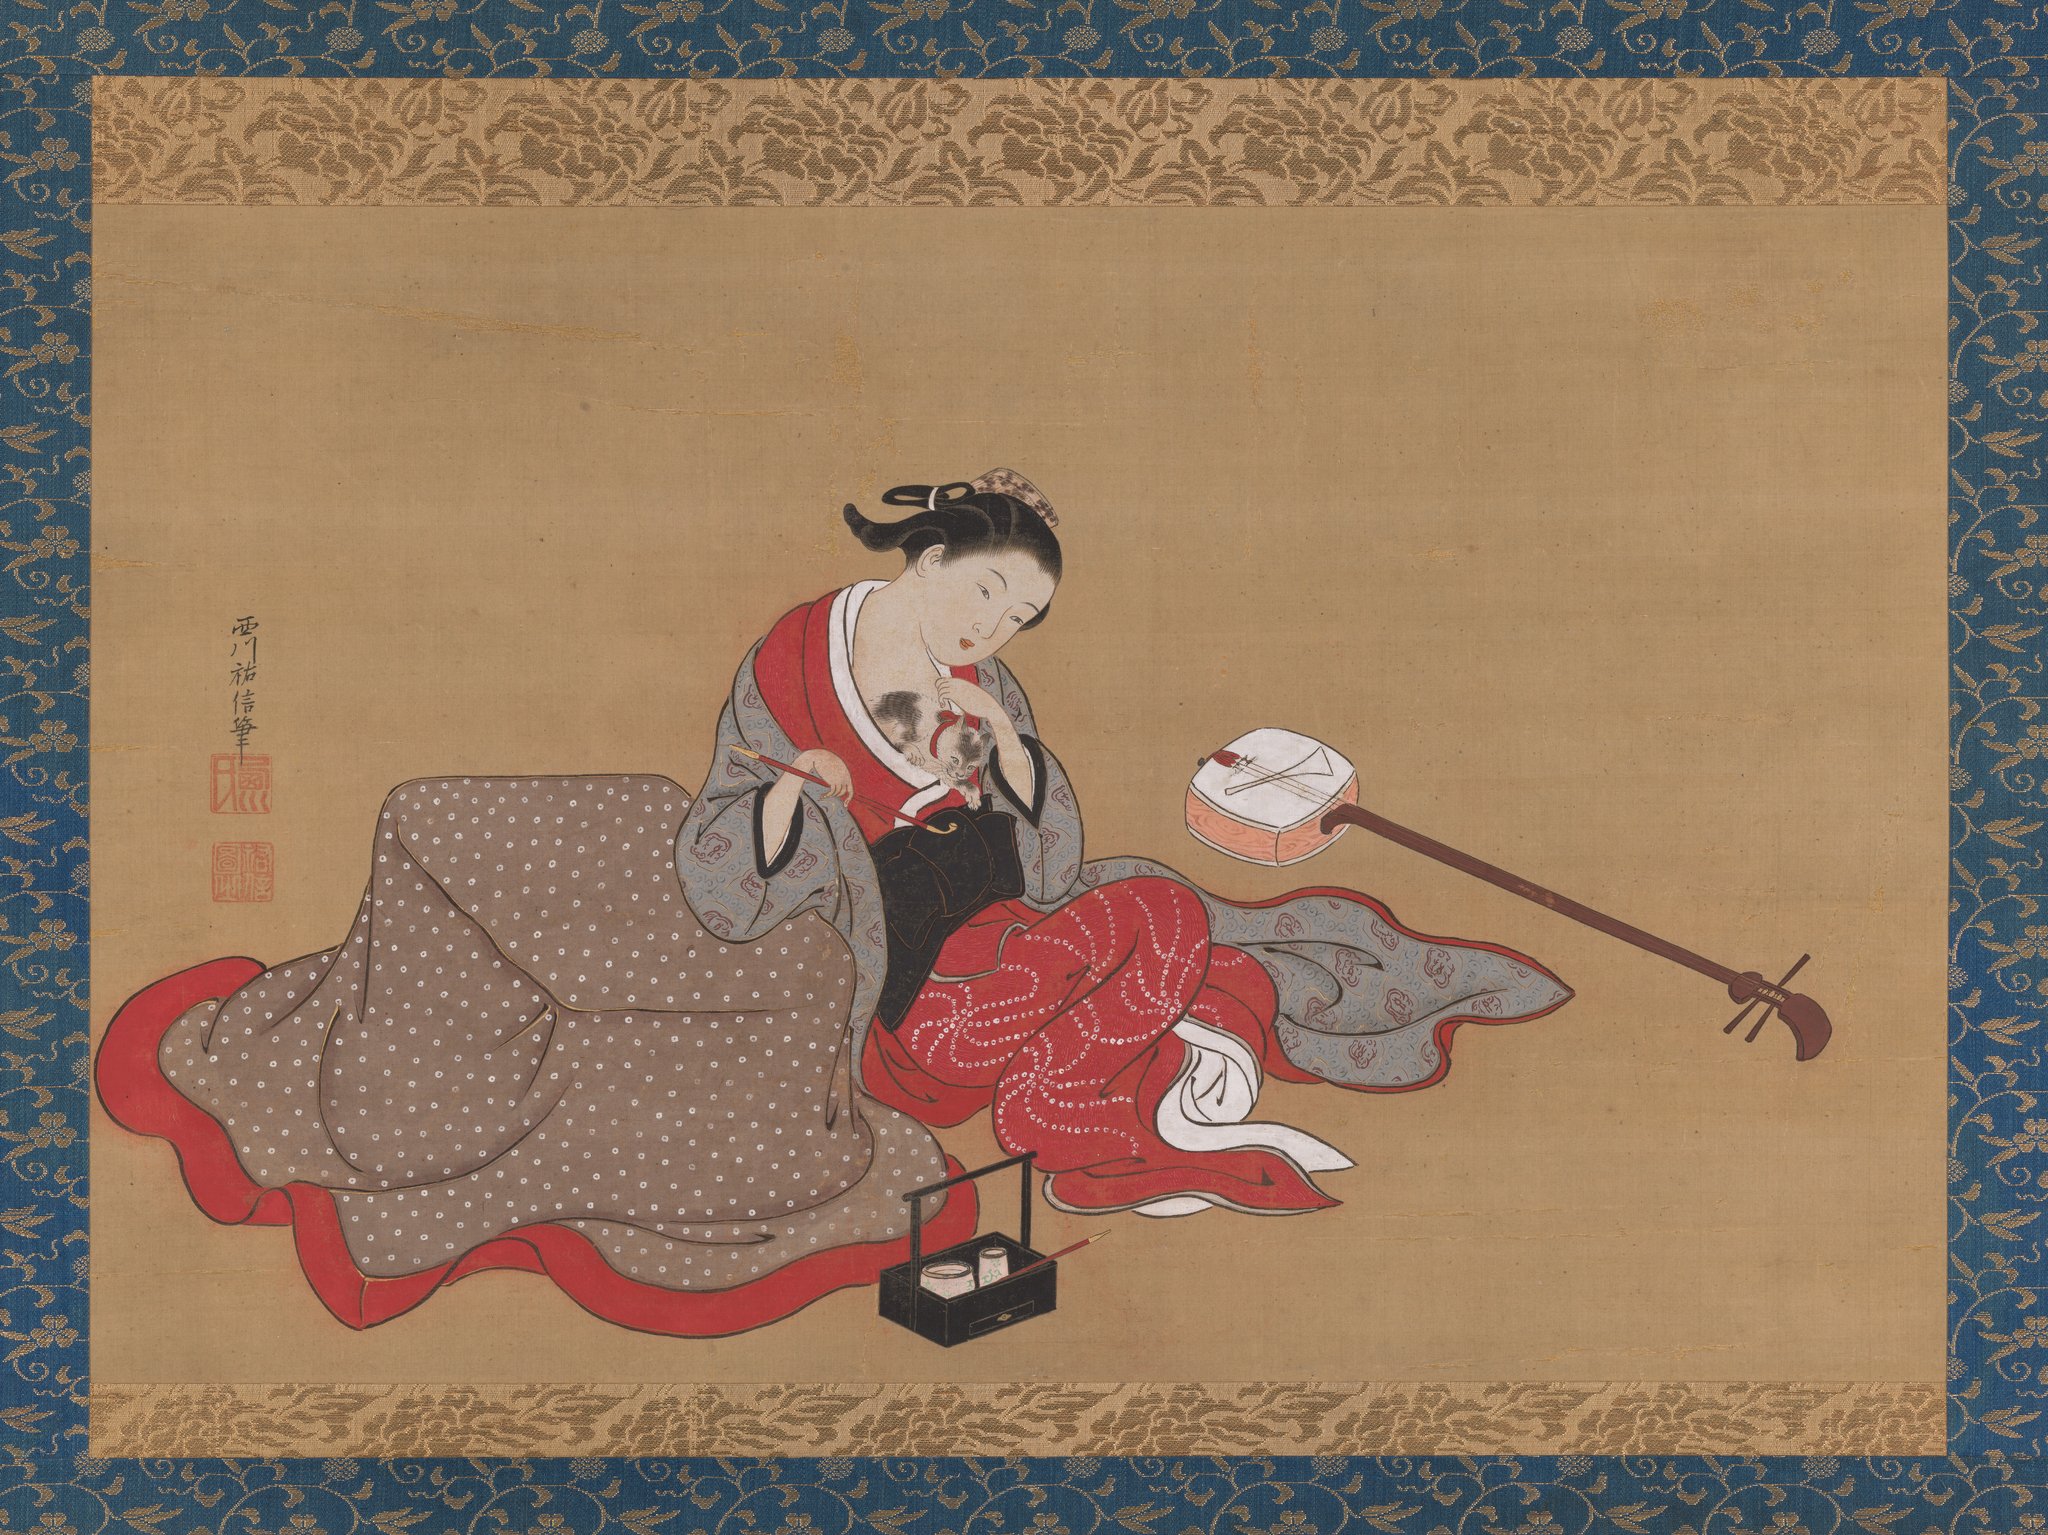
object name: hanging scroll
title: Courtesan with a Kitten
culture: japanese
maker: nishikawa sukenobu 西川祐信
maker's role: artist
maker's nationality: japanese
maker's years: 1671-1750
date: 1701-1733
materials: gold, ink, silk